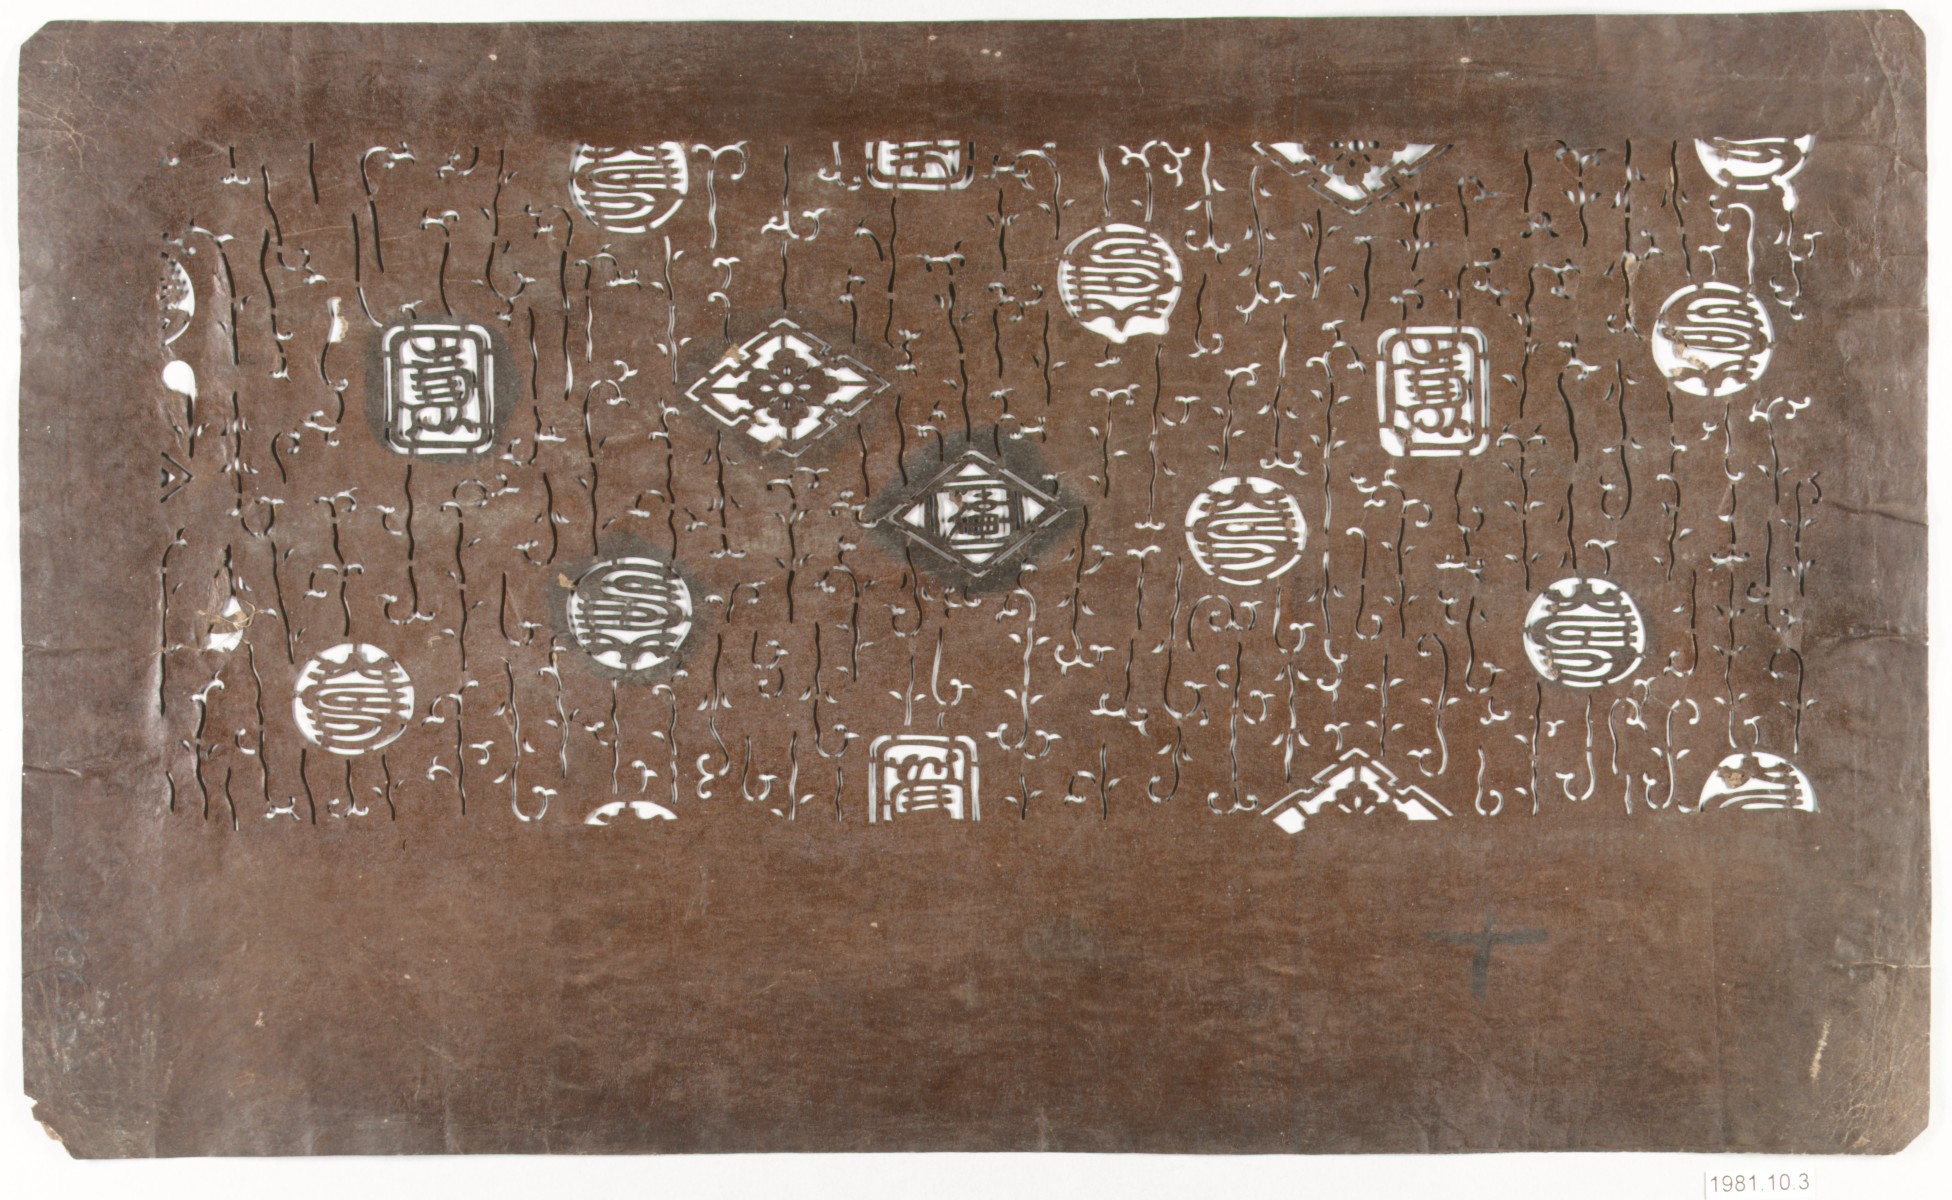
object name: stencil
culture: japanese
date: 1801-1900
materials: paper